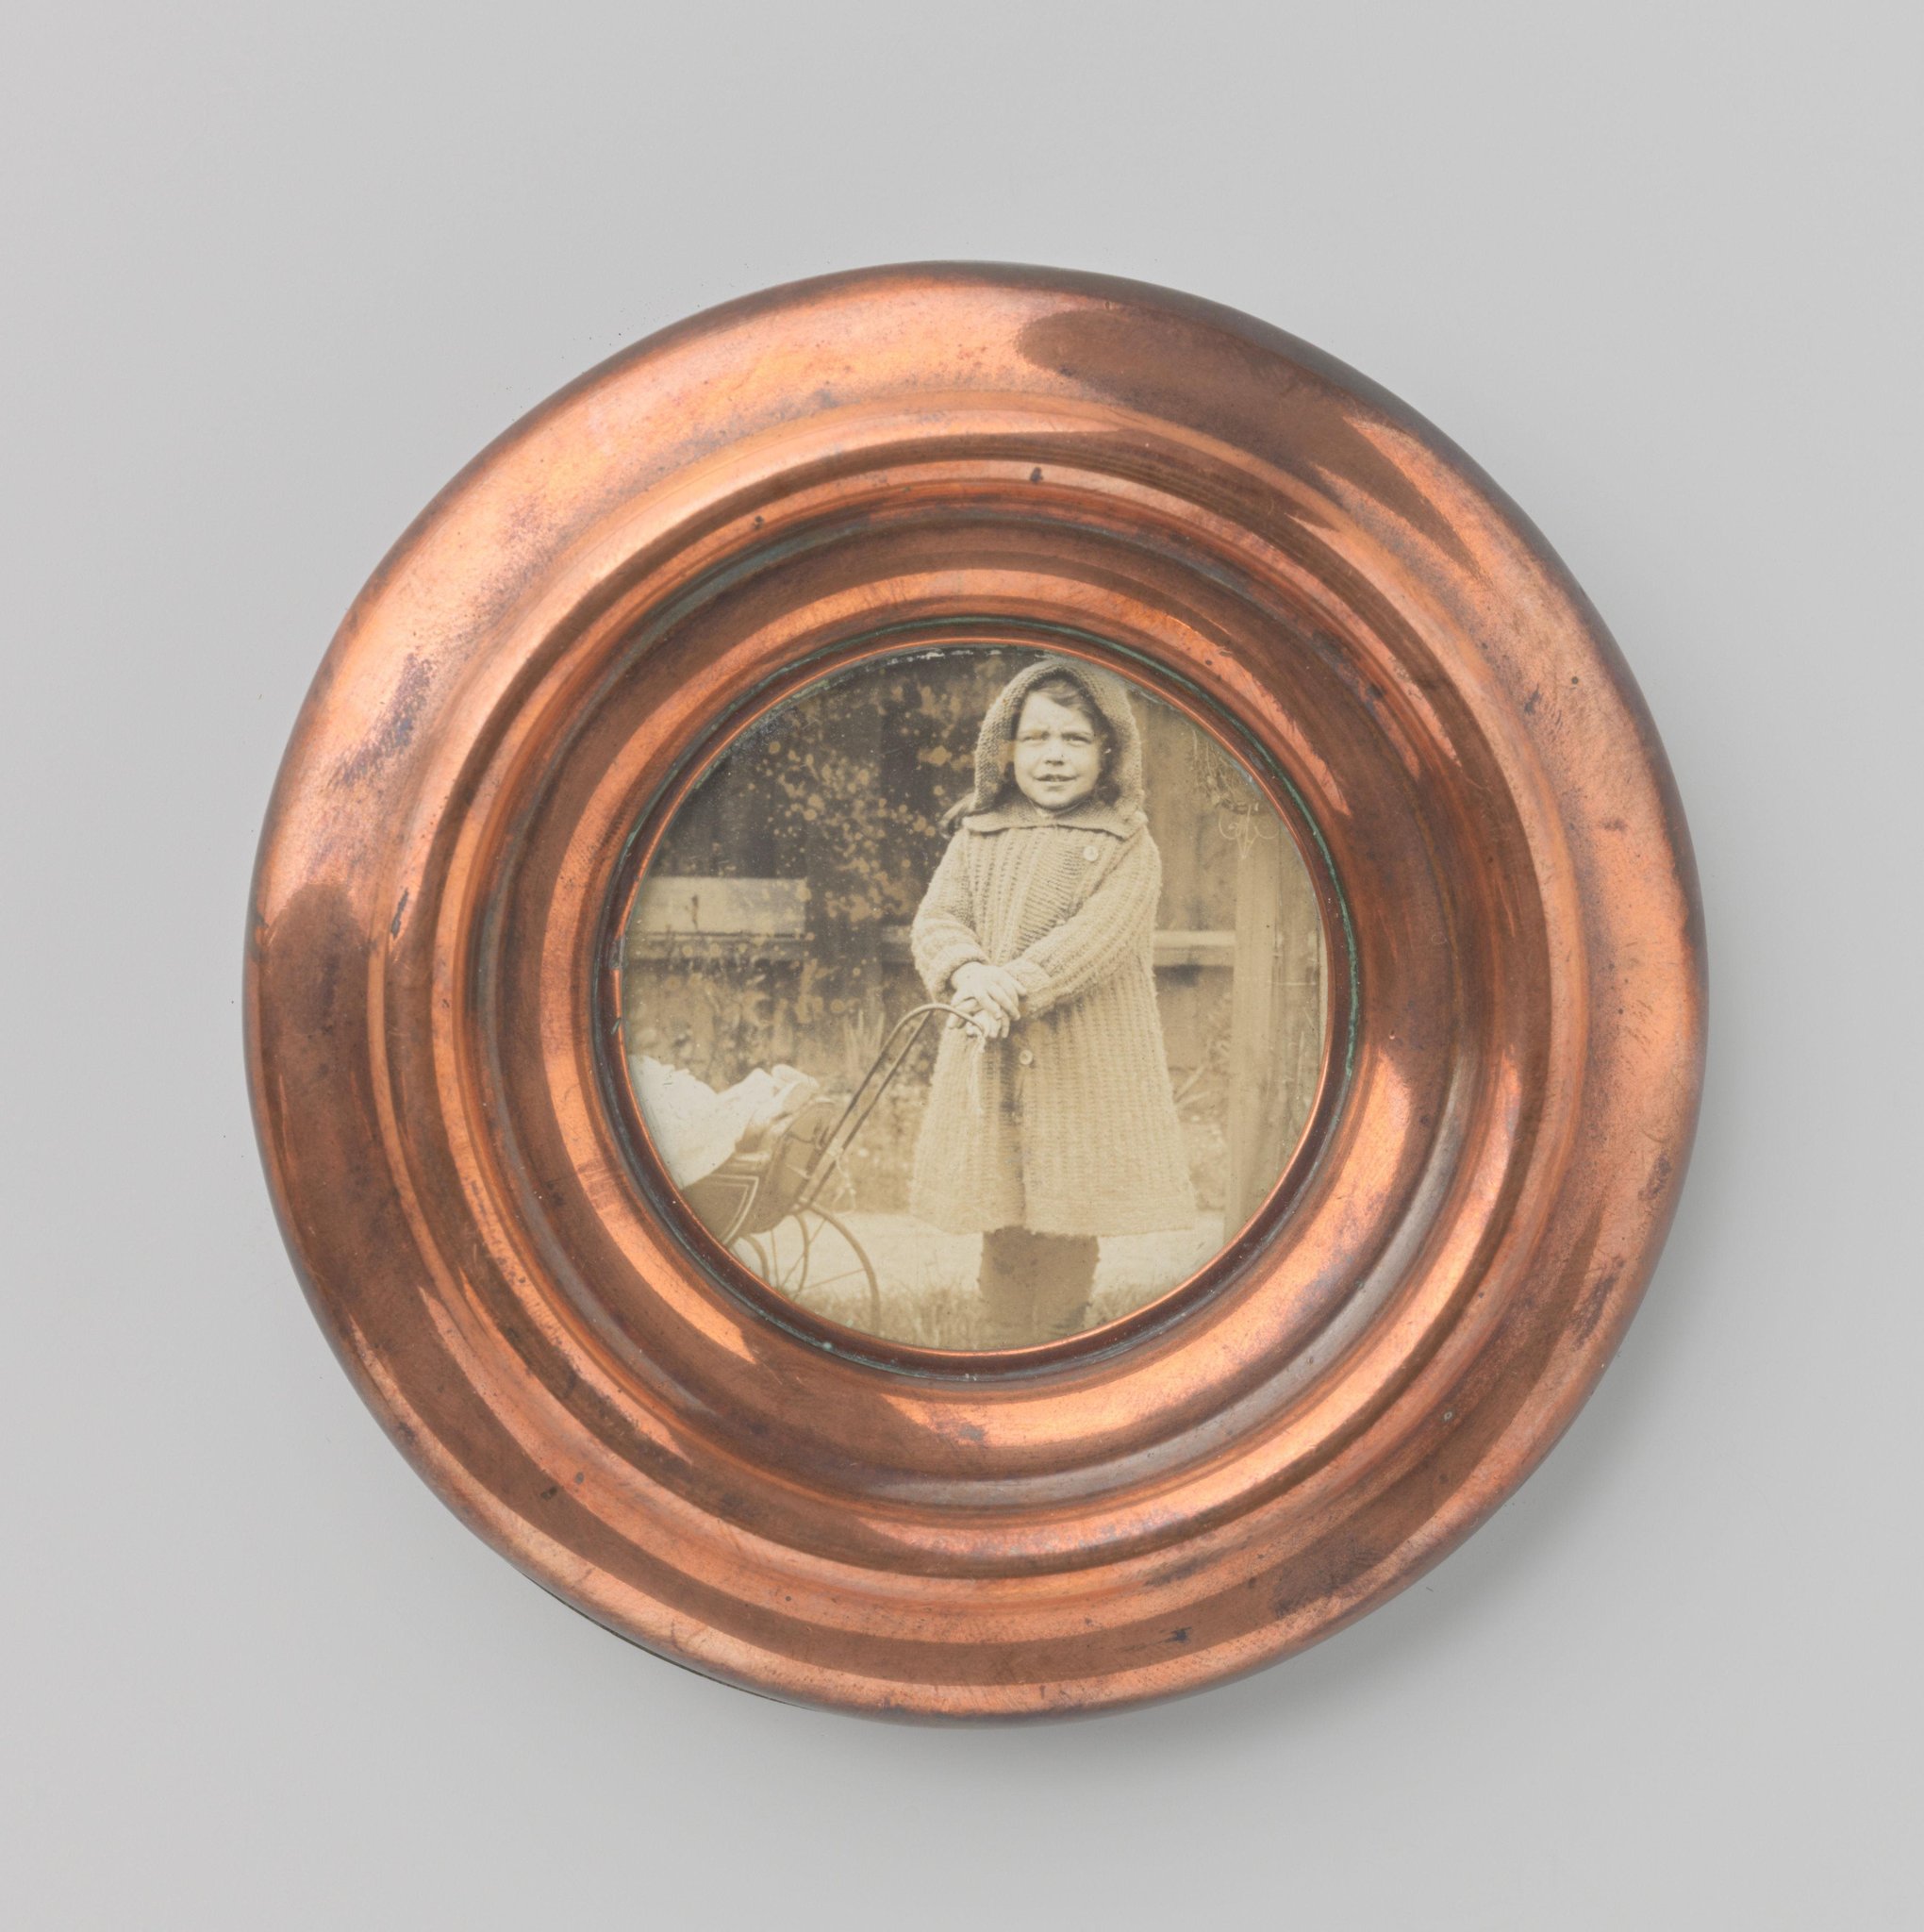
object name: frame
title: Portret van een onbekend meisje met poppenwagen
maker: Anonymous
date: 1880-1900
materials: paper, glass, metal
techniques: gelatin silver print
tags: baby-carriage, pram, perambulator, girl (child between toddler and youth), anonymous historical person portrayed